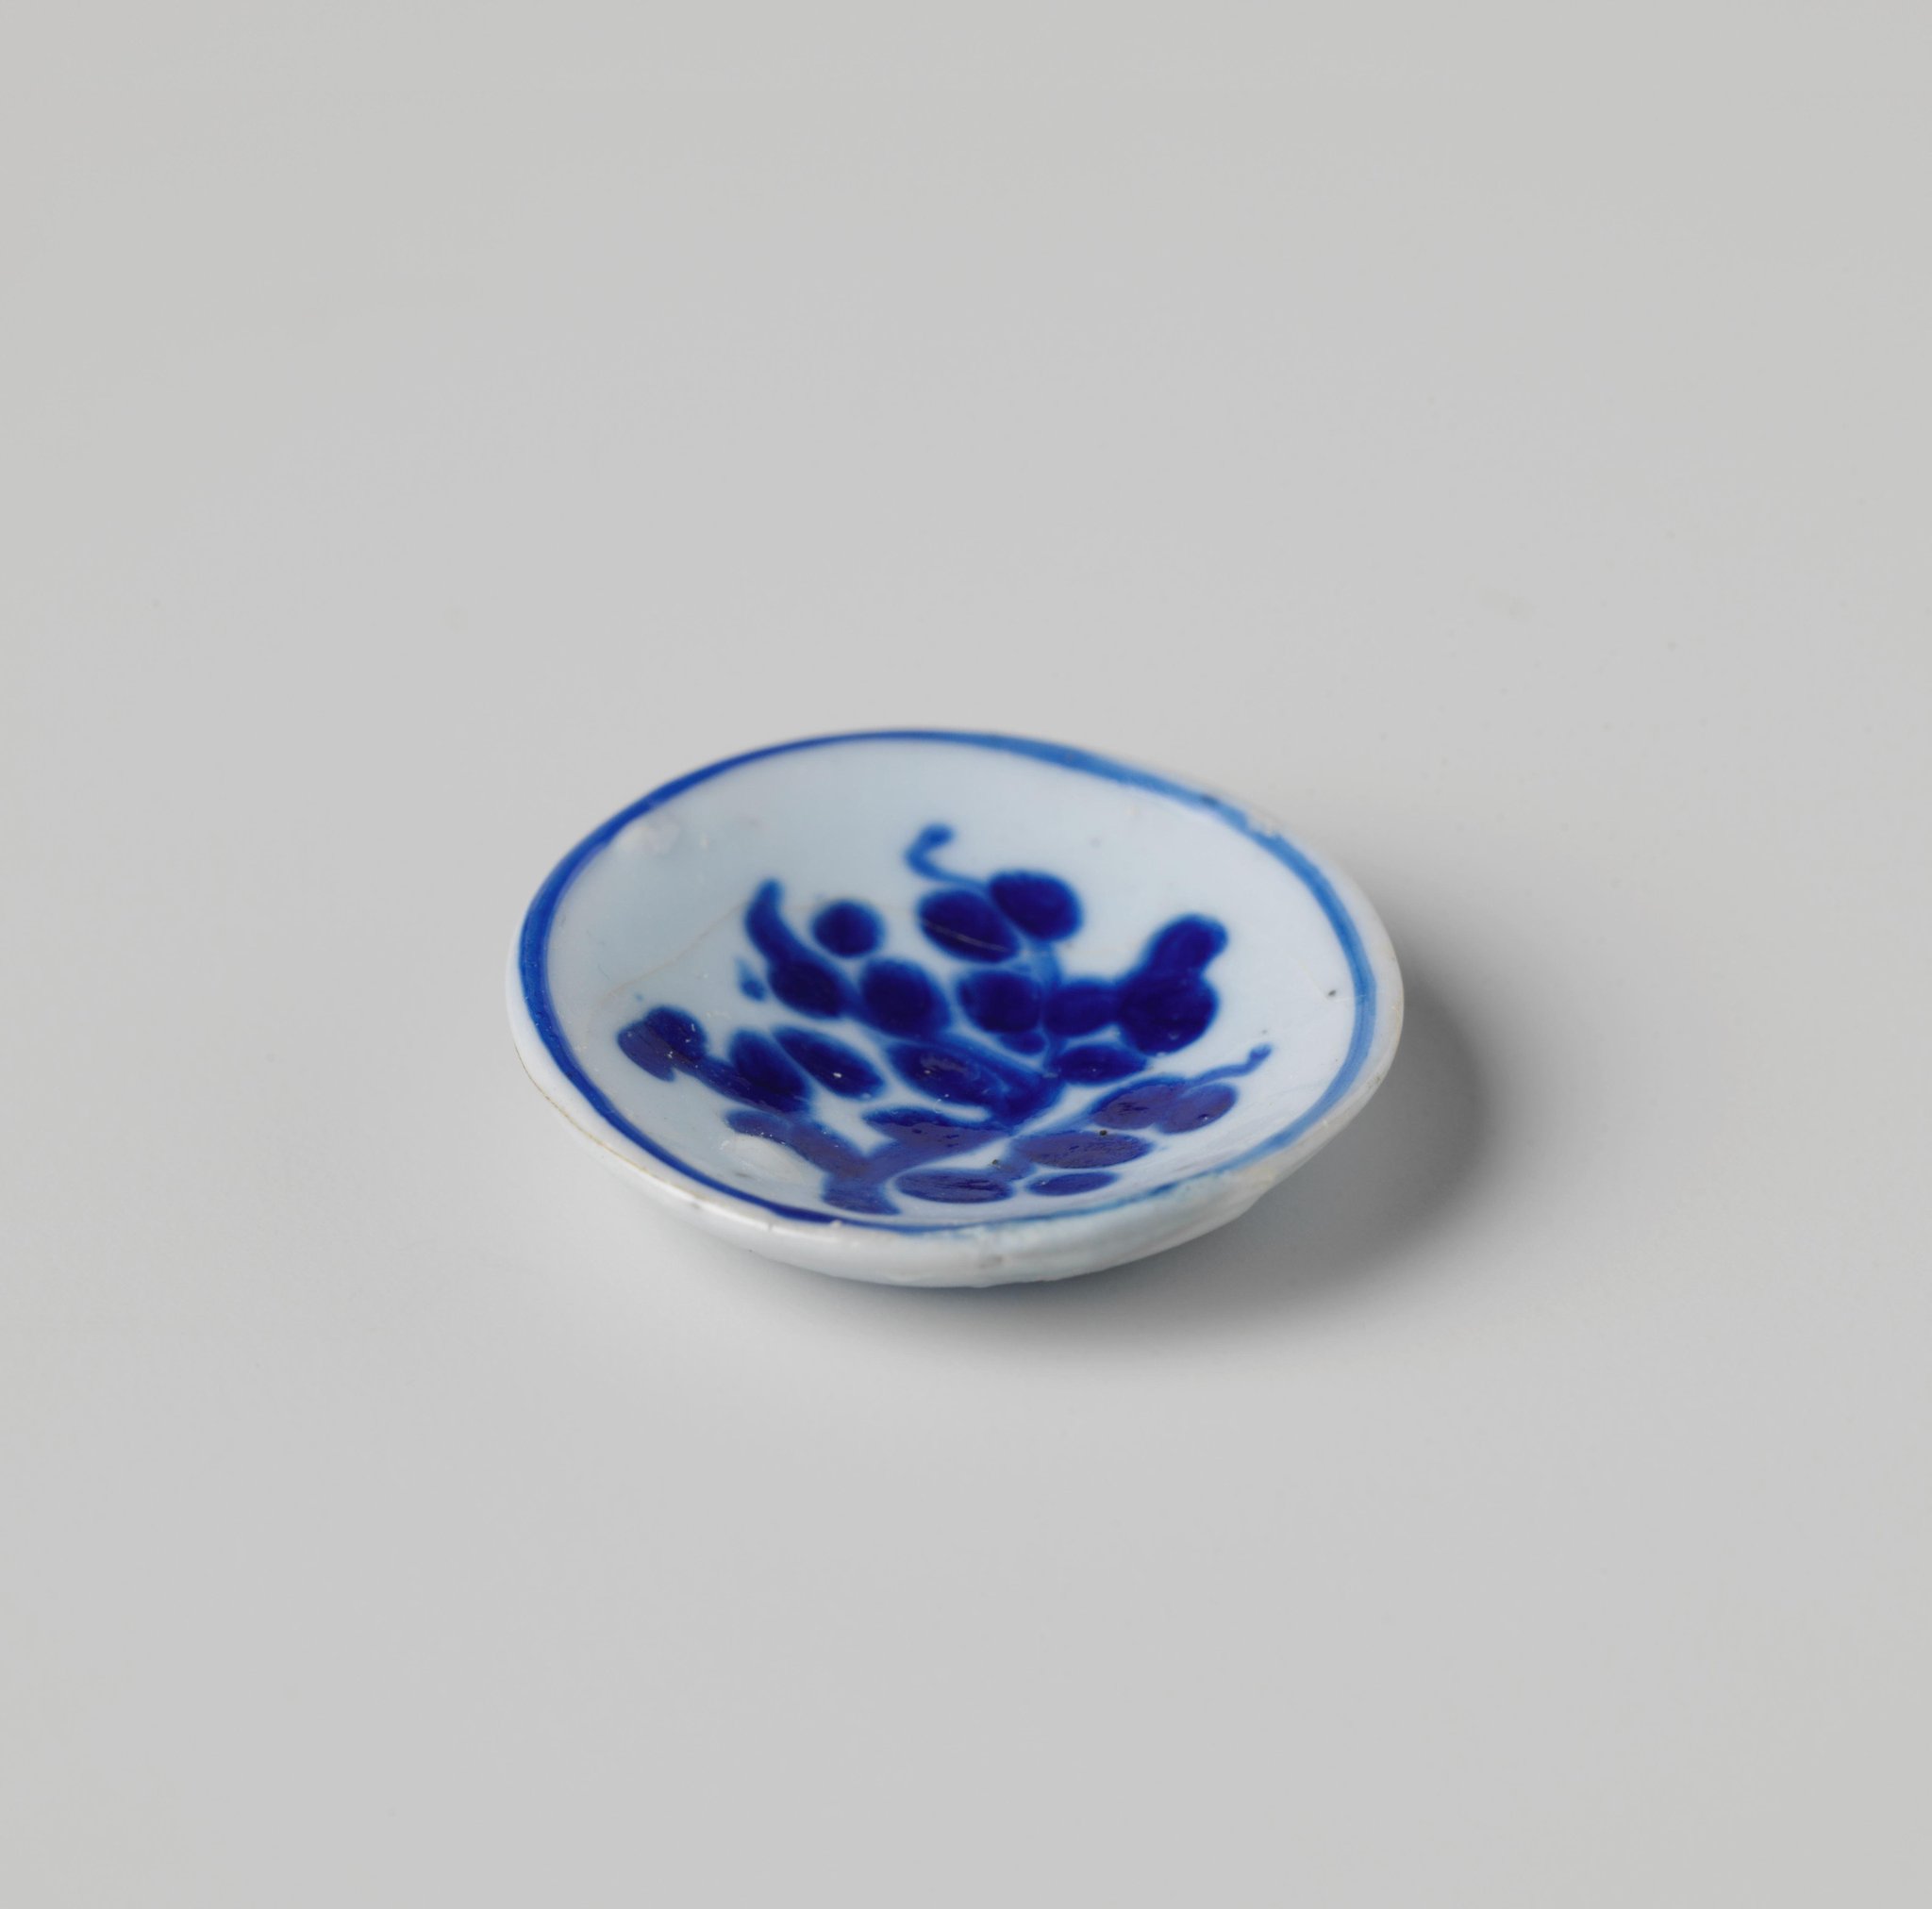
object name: miniature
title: Bord, wit, beschilderd in blauw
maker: Anonymous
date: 1675-1699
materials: glass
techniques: enamel painting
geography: amsterdam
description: Twee borden van melkglas met blauwe emailverf beschildering; dubbele laag, hol van binnen.